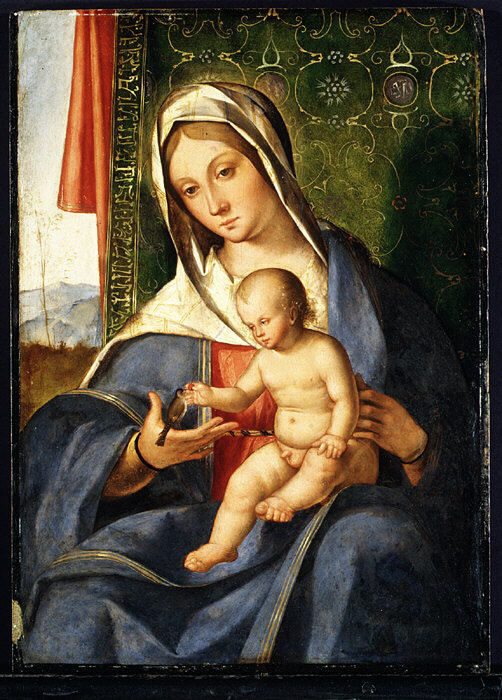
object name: painting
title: Madonna and Child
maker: boccaccio boccaccino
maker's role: artist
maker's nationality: italian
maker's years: 1466-1525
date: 1506-1518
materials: oil, wood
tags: birds,madonna and child